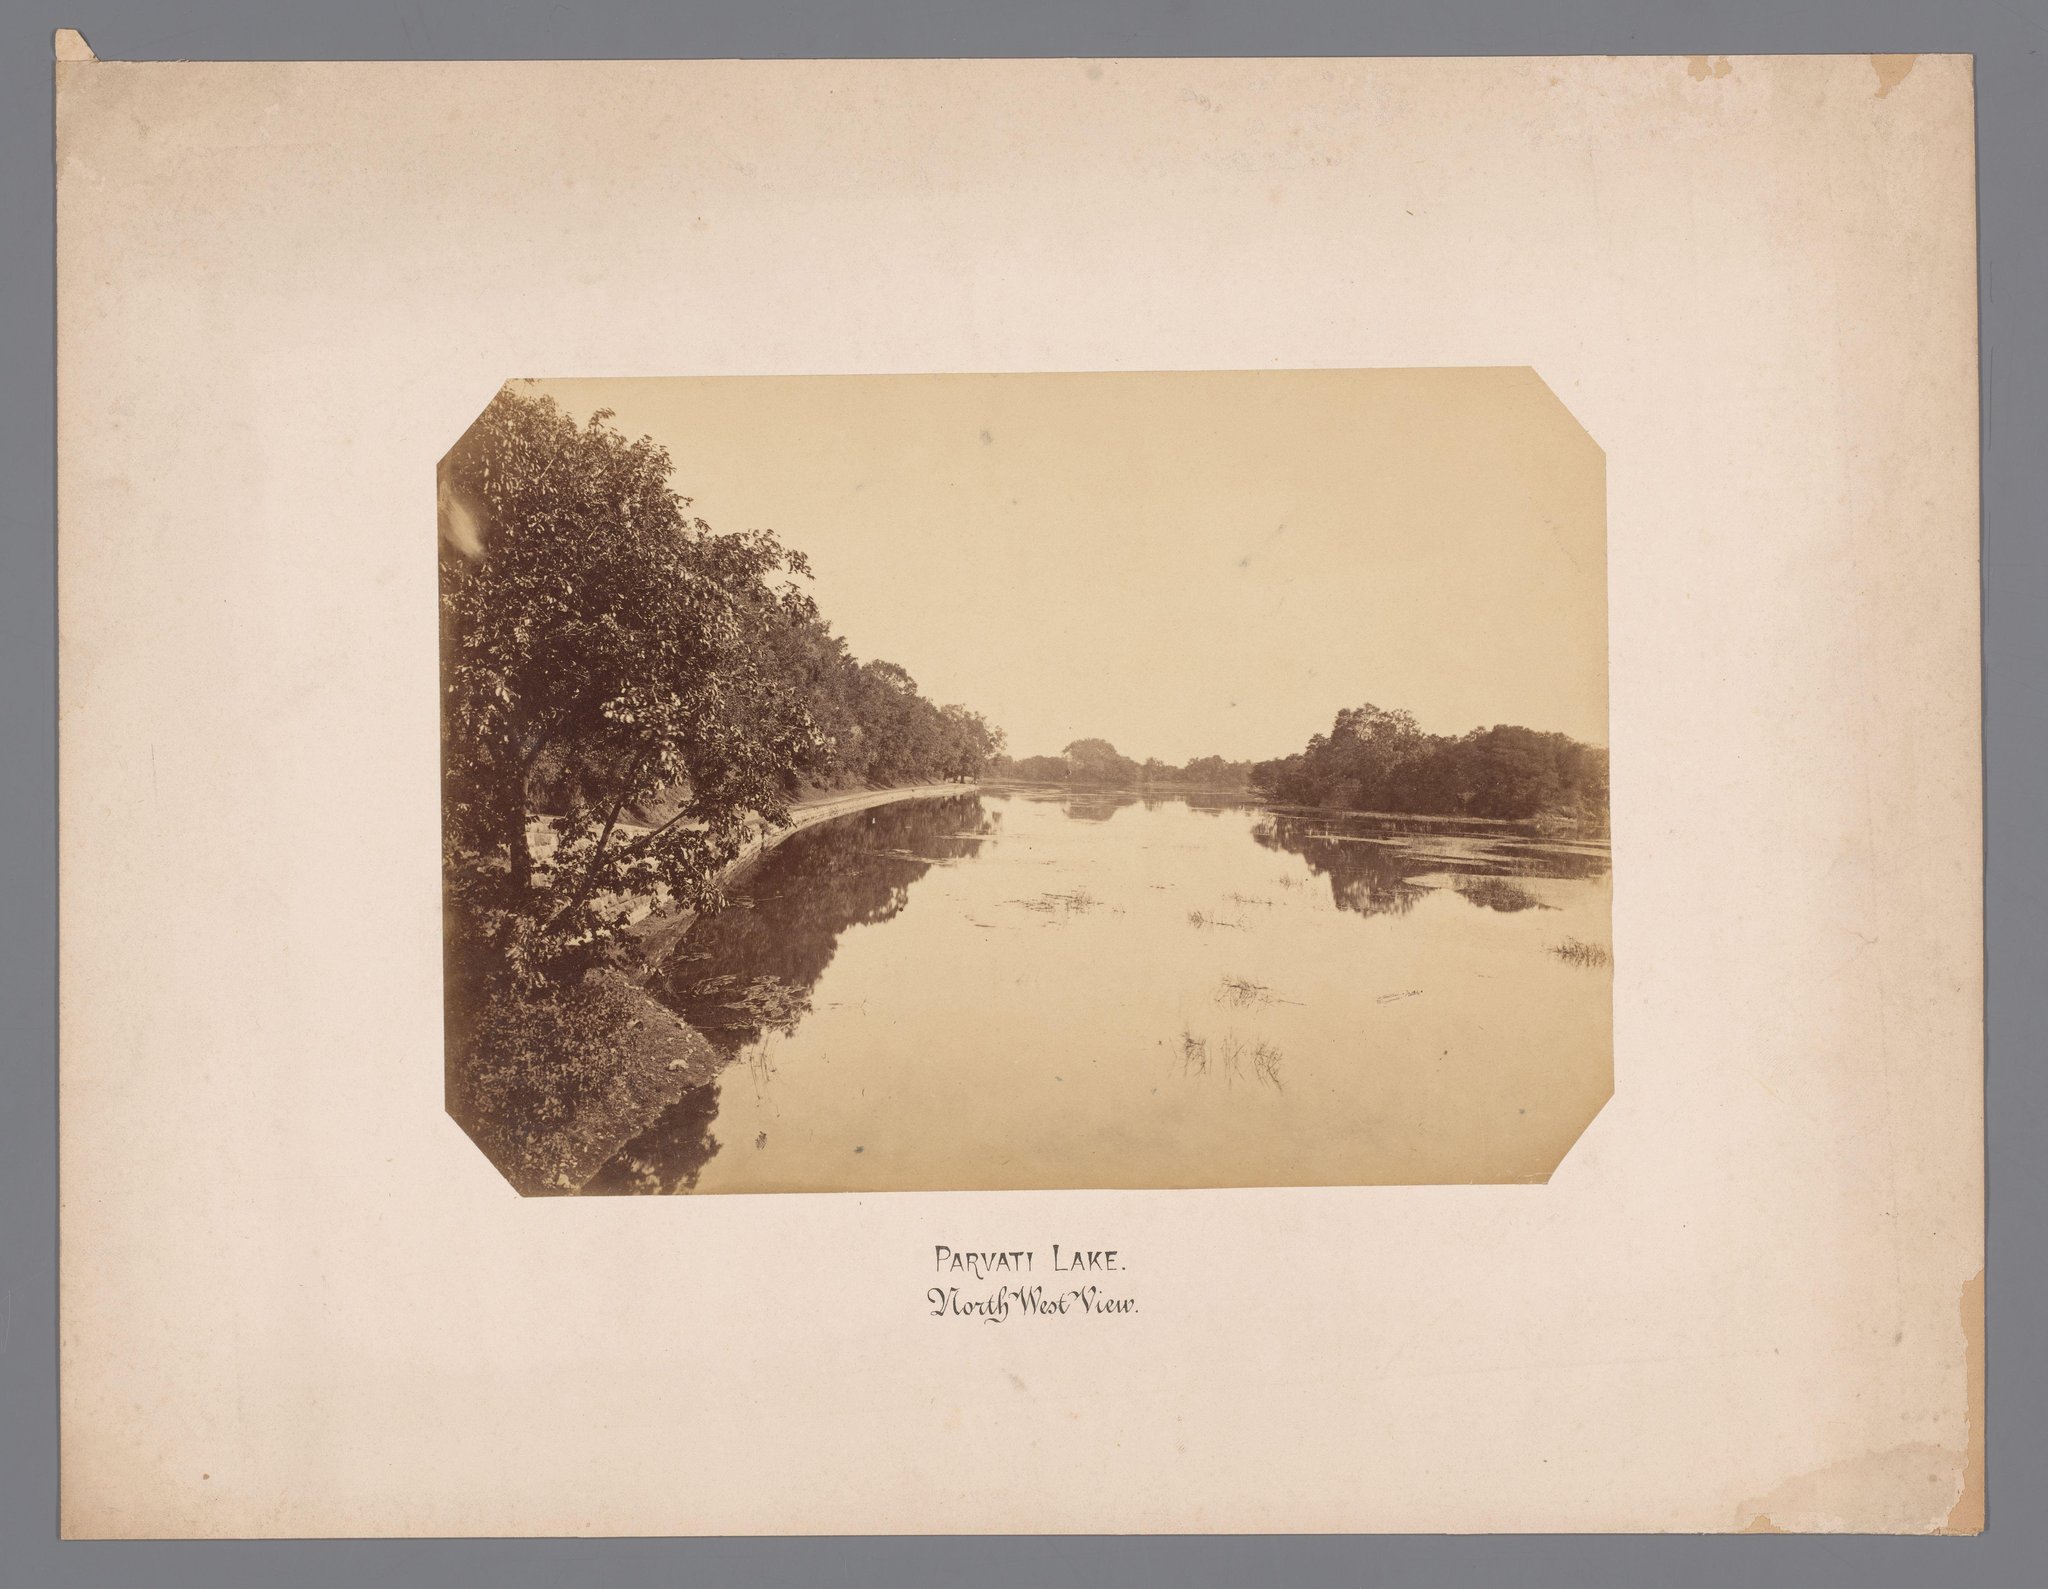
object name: photograph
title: Parvati Lake, India. Vanuit het noordwesten gezien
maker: Anonymous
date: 1875-1900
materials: cardboard, photographic support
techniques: albumen print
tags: india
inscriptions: inscription: ‘Parvati Lake//North-West’, inscription: ‘Parvati Lake//North-West View’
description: Parvati Lake, India. Vanuit het noordwesten gezien.